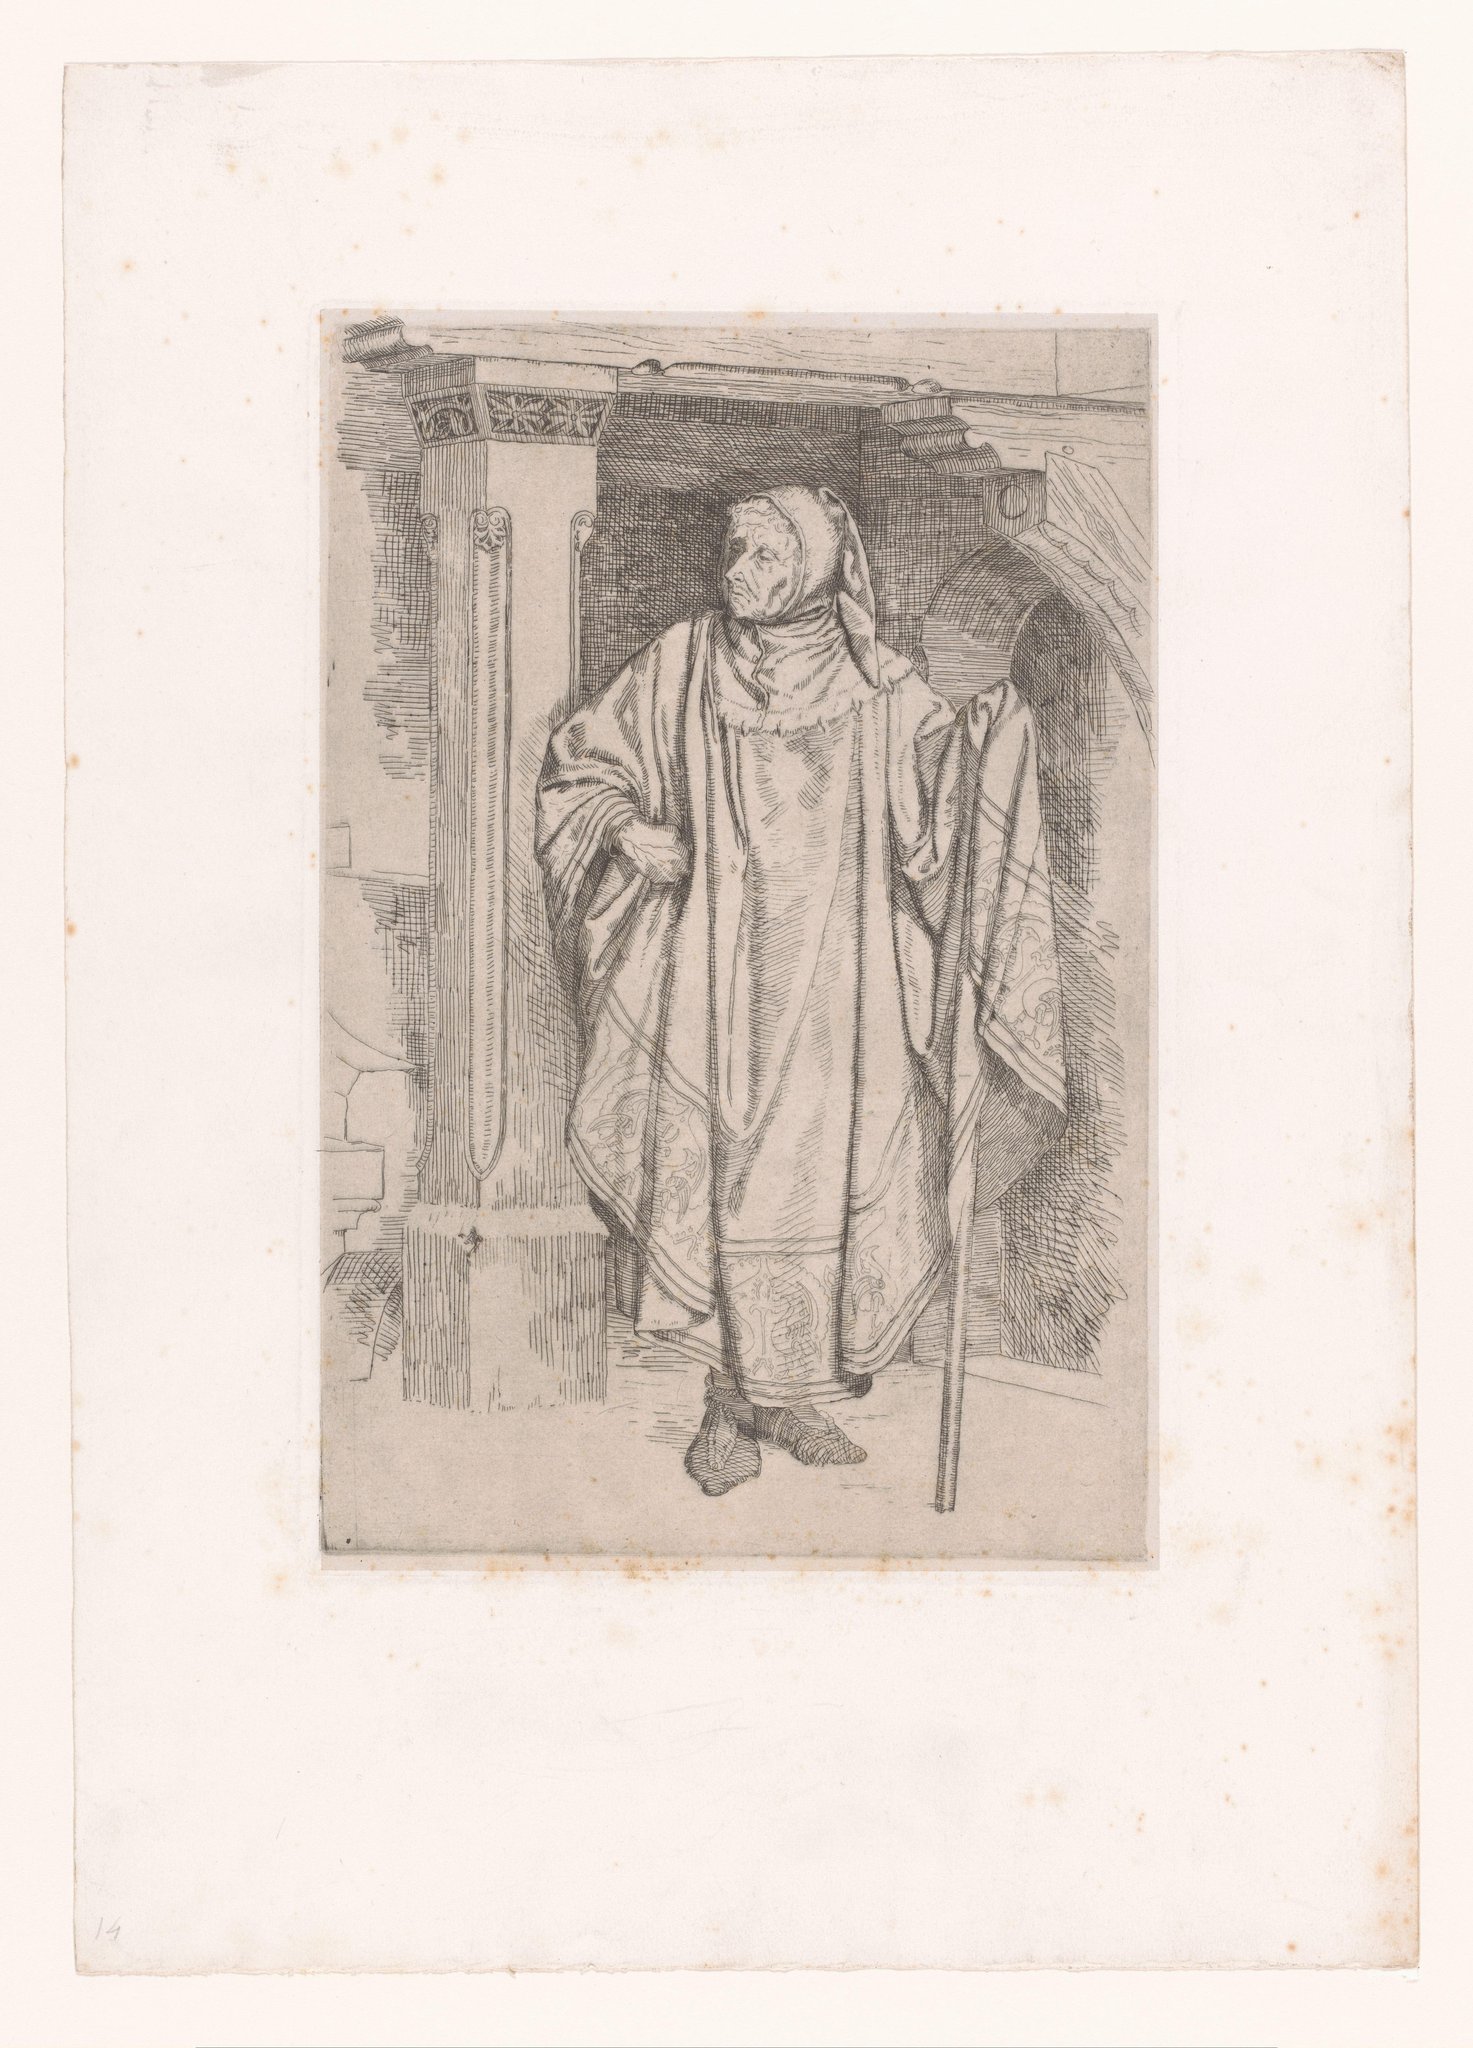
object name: print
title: Oude man met kapmantel en wandelstok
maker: juliaan de vriendt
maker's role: print maker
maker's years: 1842-1935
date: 1871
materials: paper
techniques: etching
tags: walking-stick, staff, old man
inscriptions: collector's mark: Lugt 2228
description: Latere staat van deze prent met de titel 'De Oude van Eisenach' is verschenen in: Album du journal des Beaux-Arts, dix eaux-fortes inédites. Brussel: Decq et al., 1871.